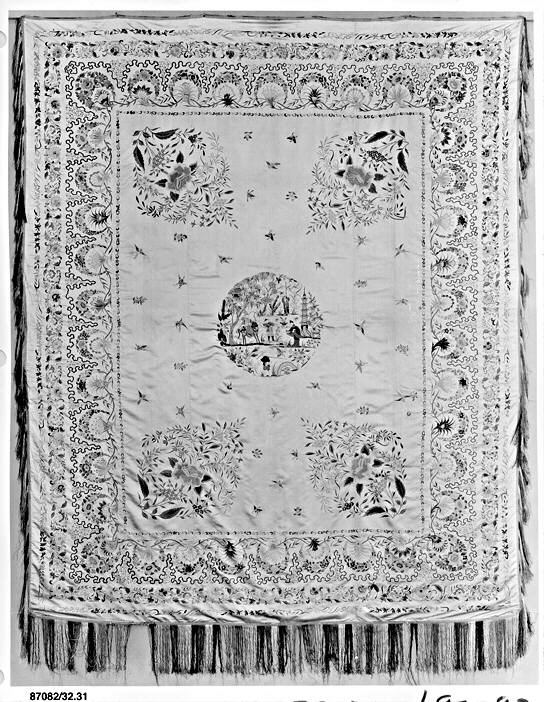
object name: bedspread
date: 1801-1900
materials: silk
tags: flowers